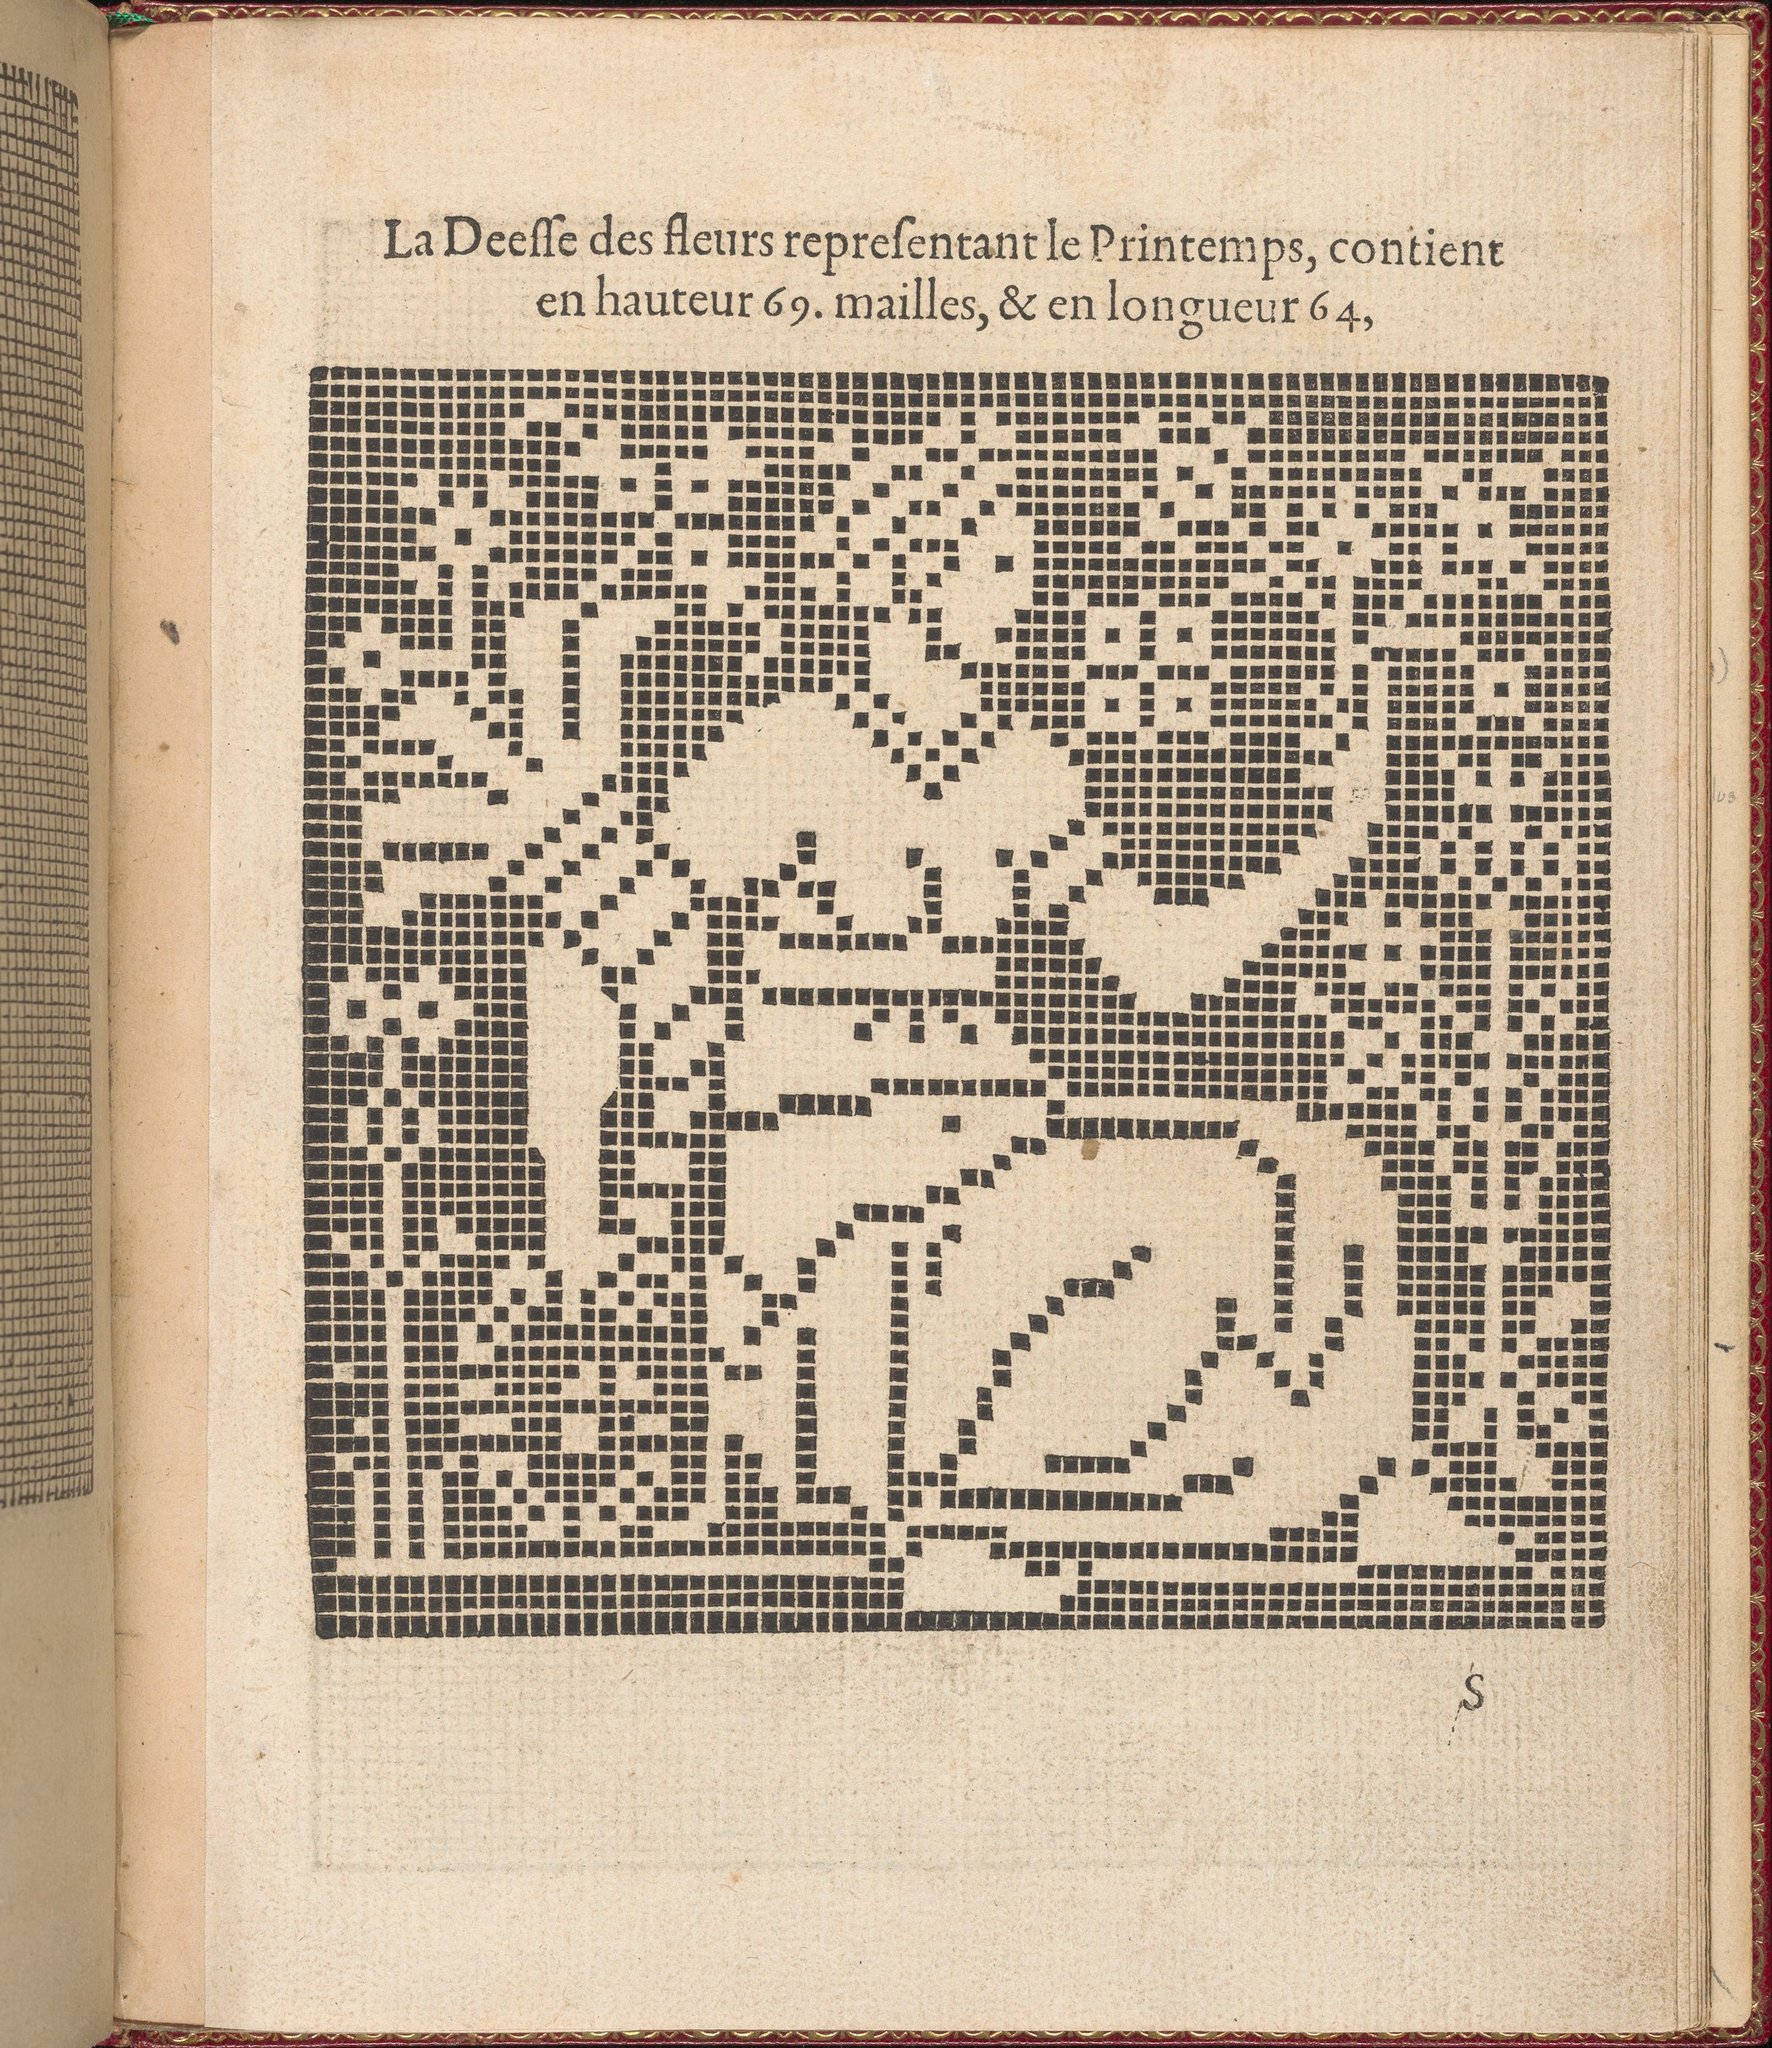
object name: book print ornament architecture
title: Les Singuliers et Nouveaux Portraicts... page 69 (recto)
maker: federico de vinciolo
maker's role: designer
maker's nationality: italian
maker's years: 1582-1599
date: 1588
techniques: woodcut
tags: cornucopia,goddess